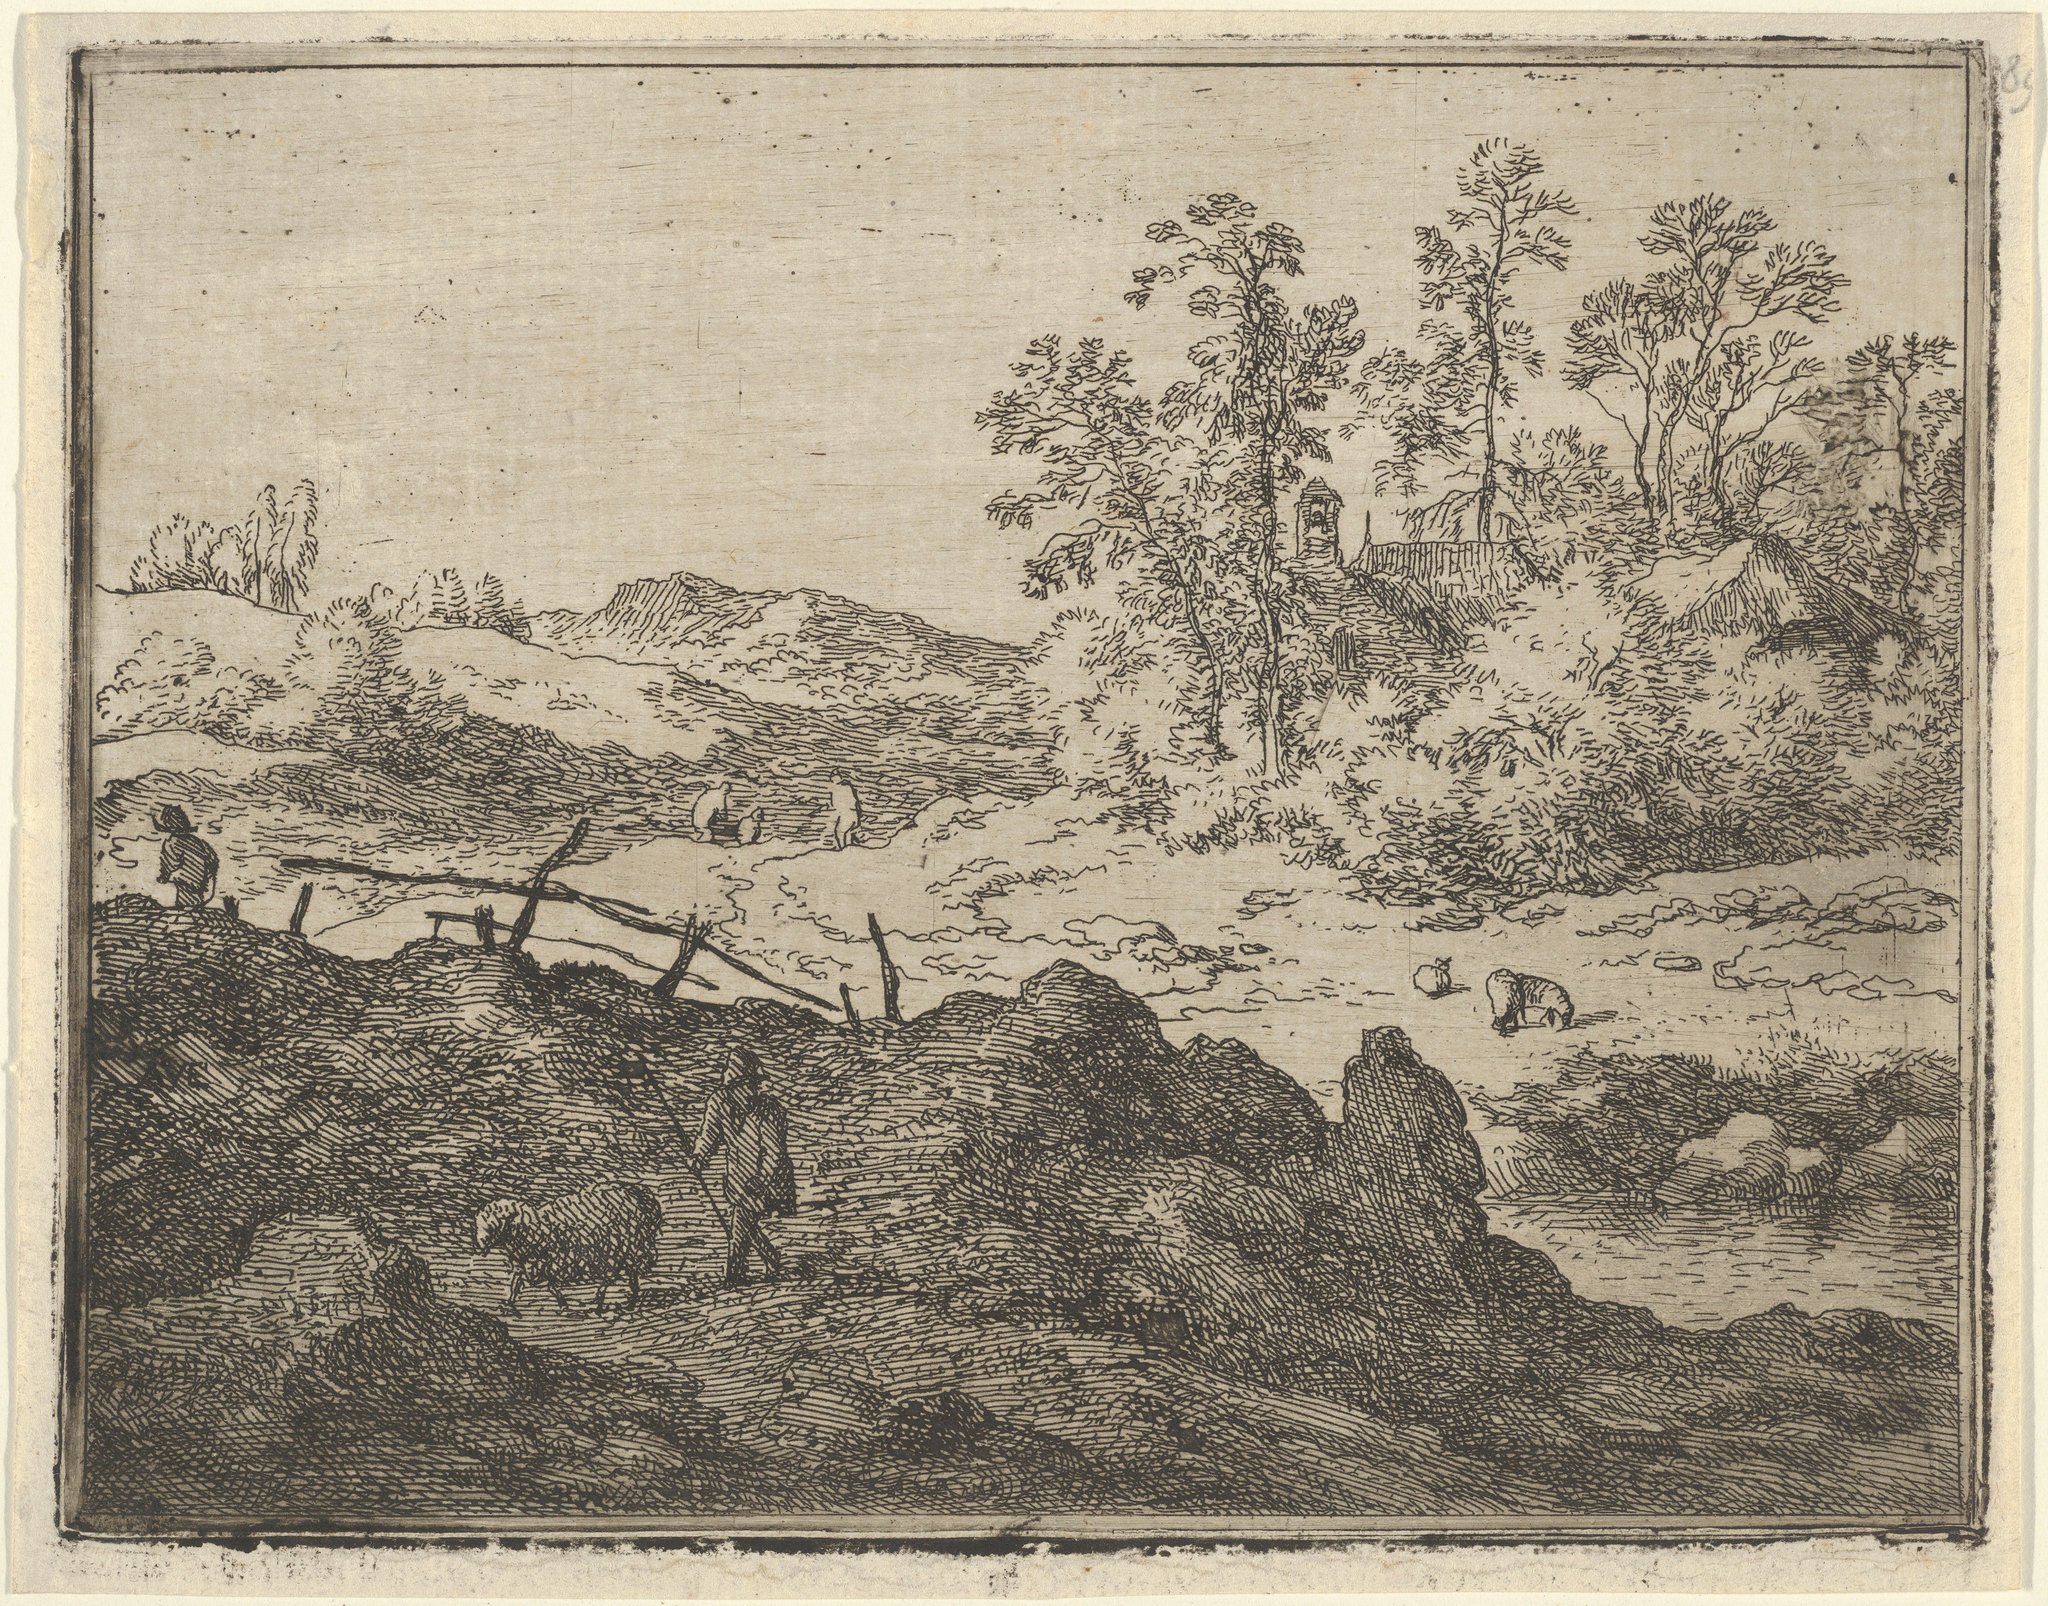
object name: print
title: The Shepherd and the Lamb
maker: allart van everdingen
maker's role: artist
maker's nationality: dutch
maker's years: 1621-1675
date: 1621-1675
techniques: engraving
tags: human figures,lambs,landscapes,trees,shepherds